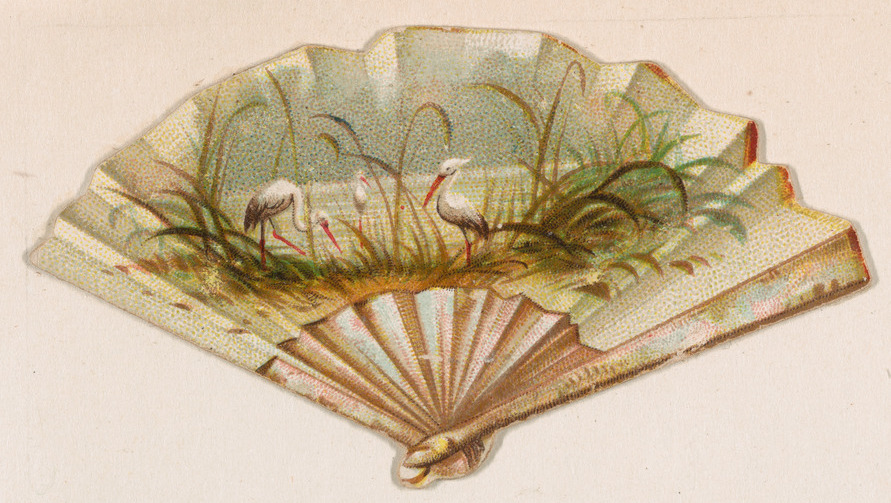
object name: print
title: Fan, from the Novelties series (N228, Type 3) issued by Kinney Bros.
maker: kinney brothers tobacco company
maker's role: publisher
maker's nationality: american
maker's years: 1869-2011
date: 1889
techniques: color lithograph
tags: birds,fans